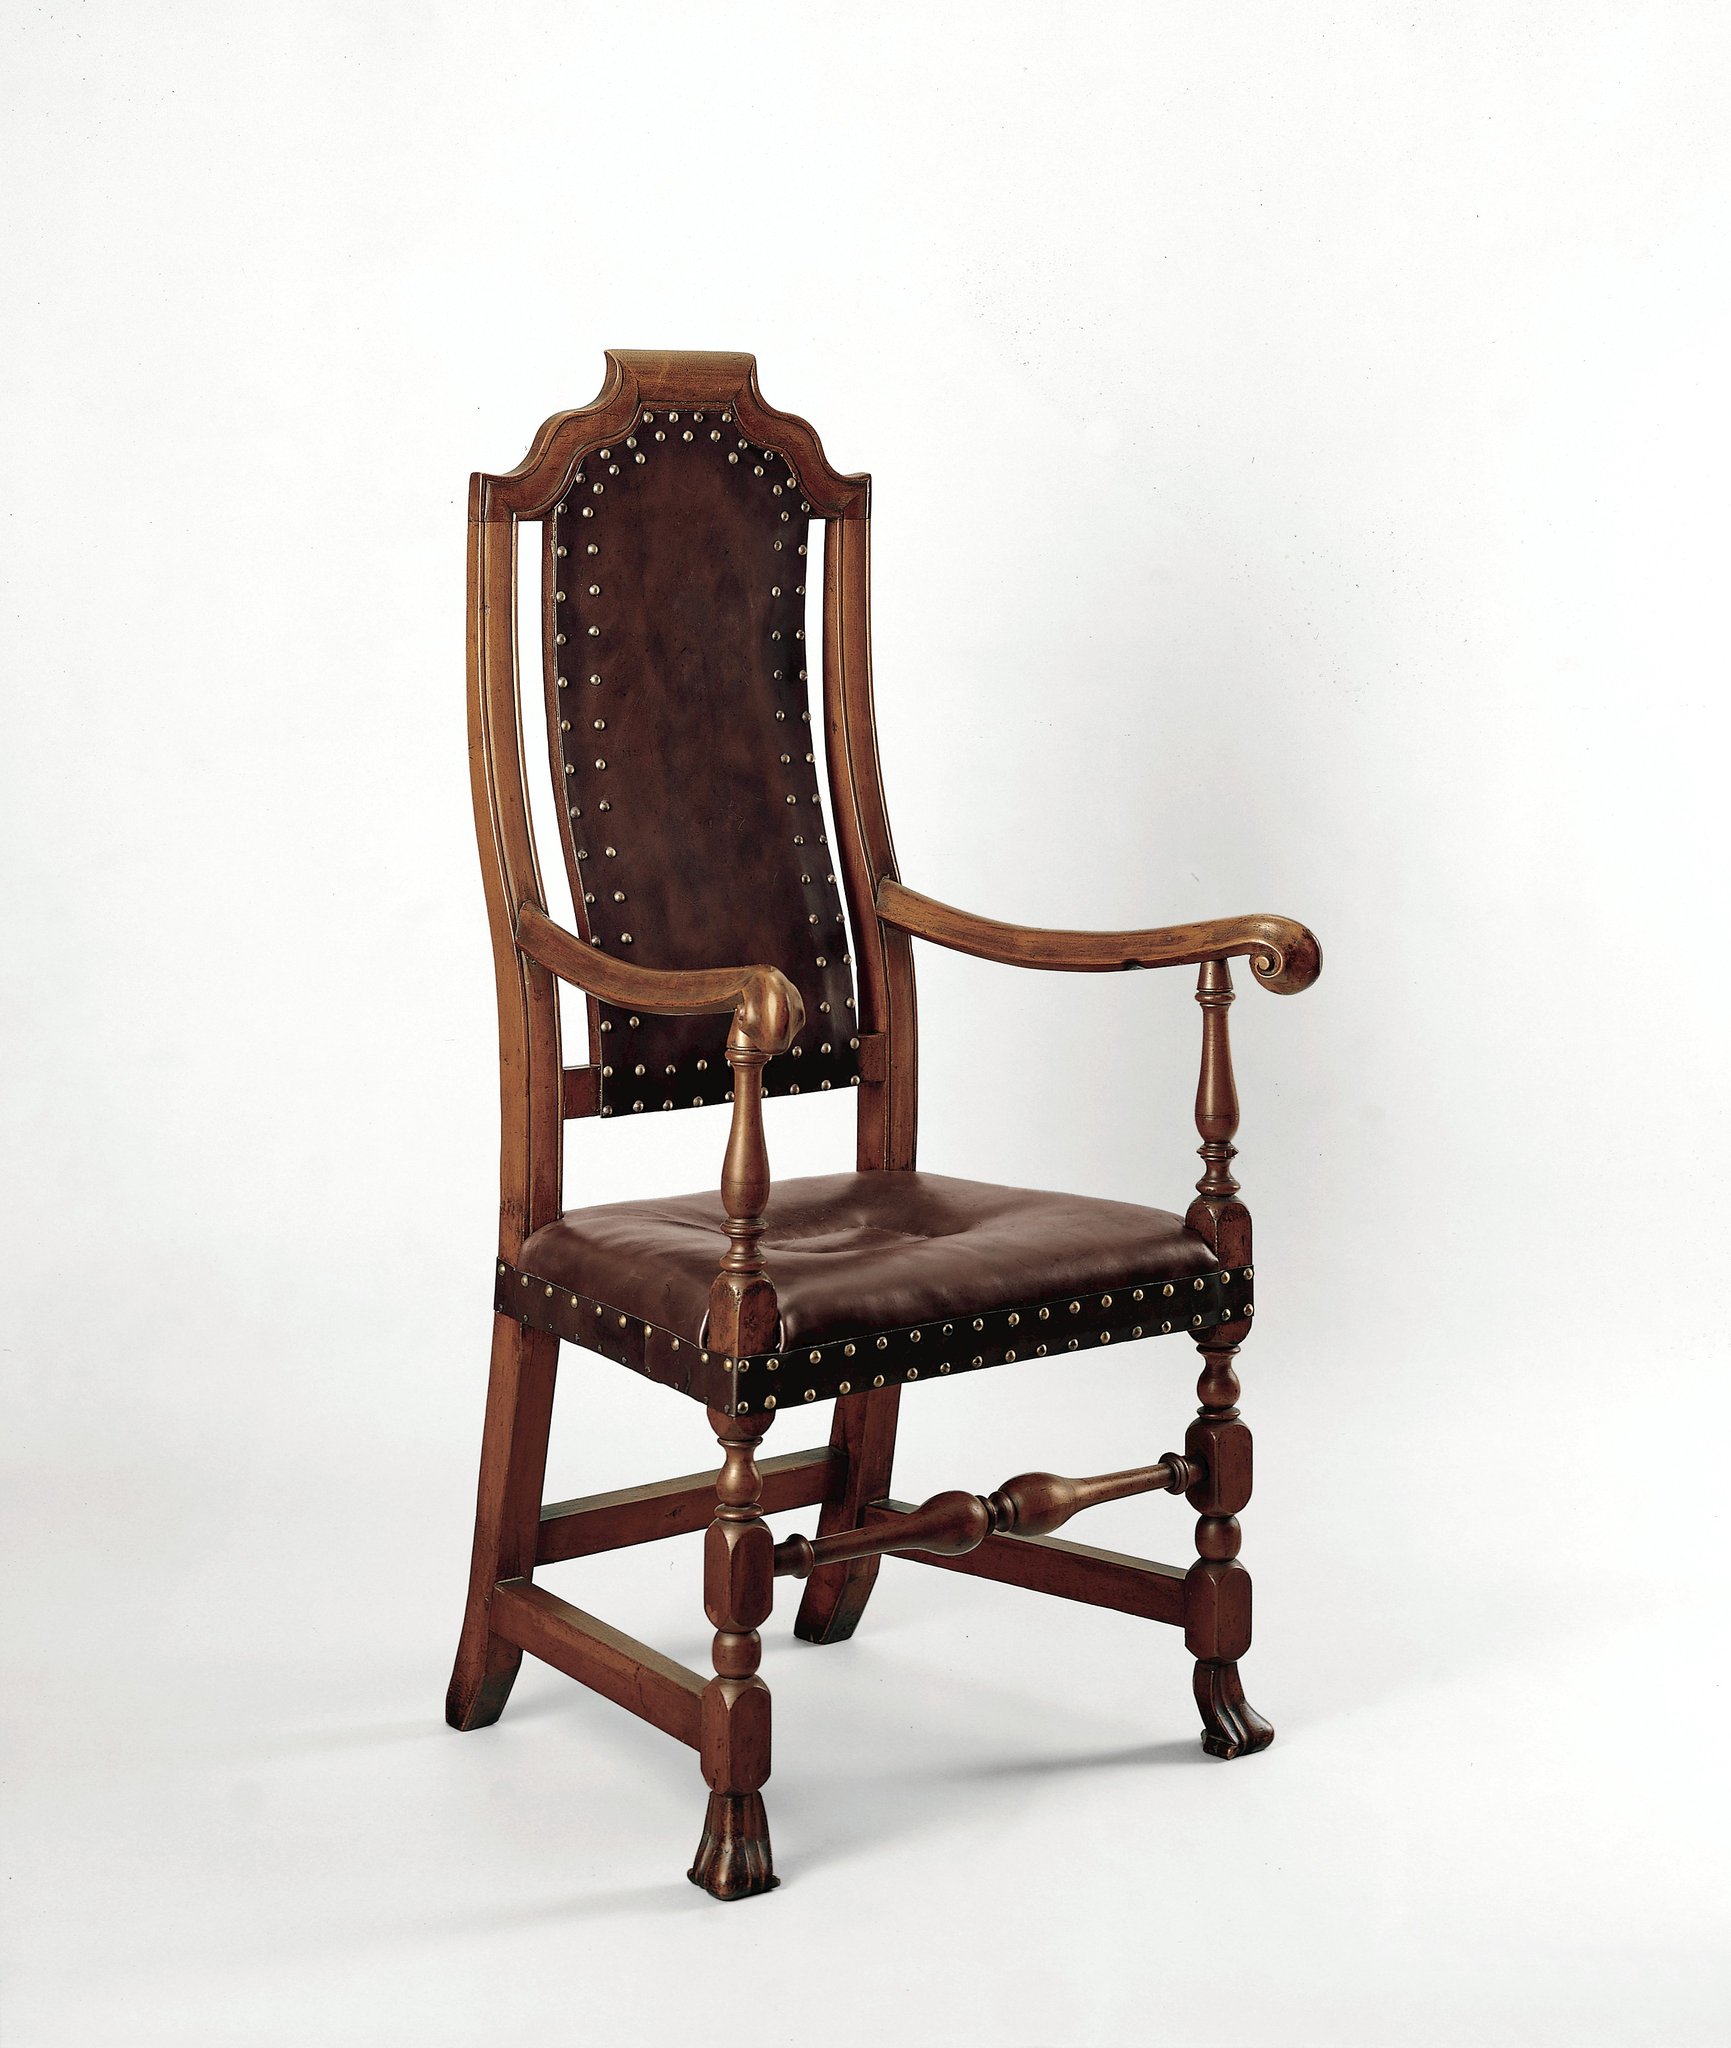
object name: armchair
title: Leather armchair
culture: american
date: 1725-1745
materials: wood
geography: mid-atlantic